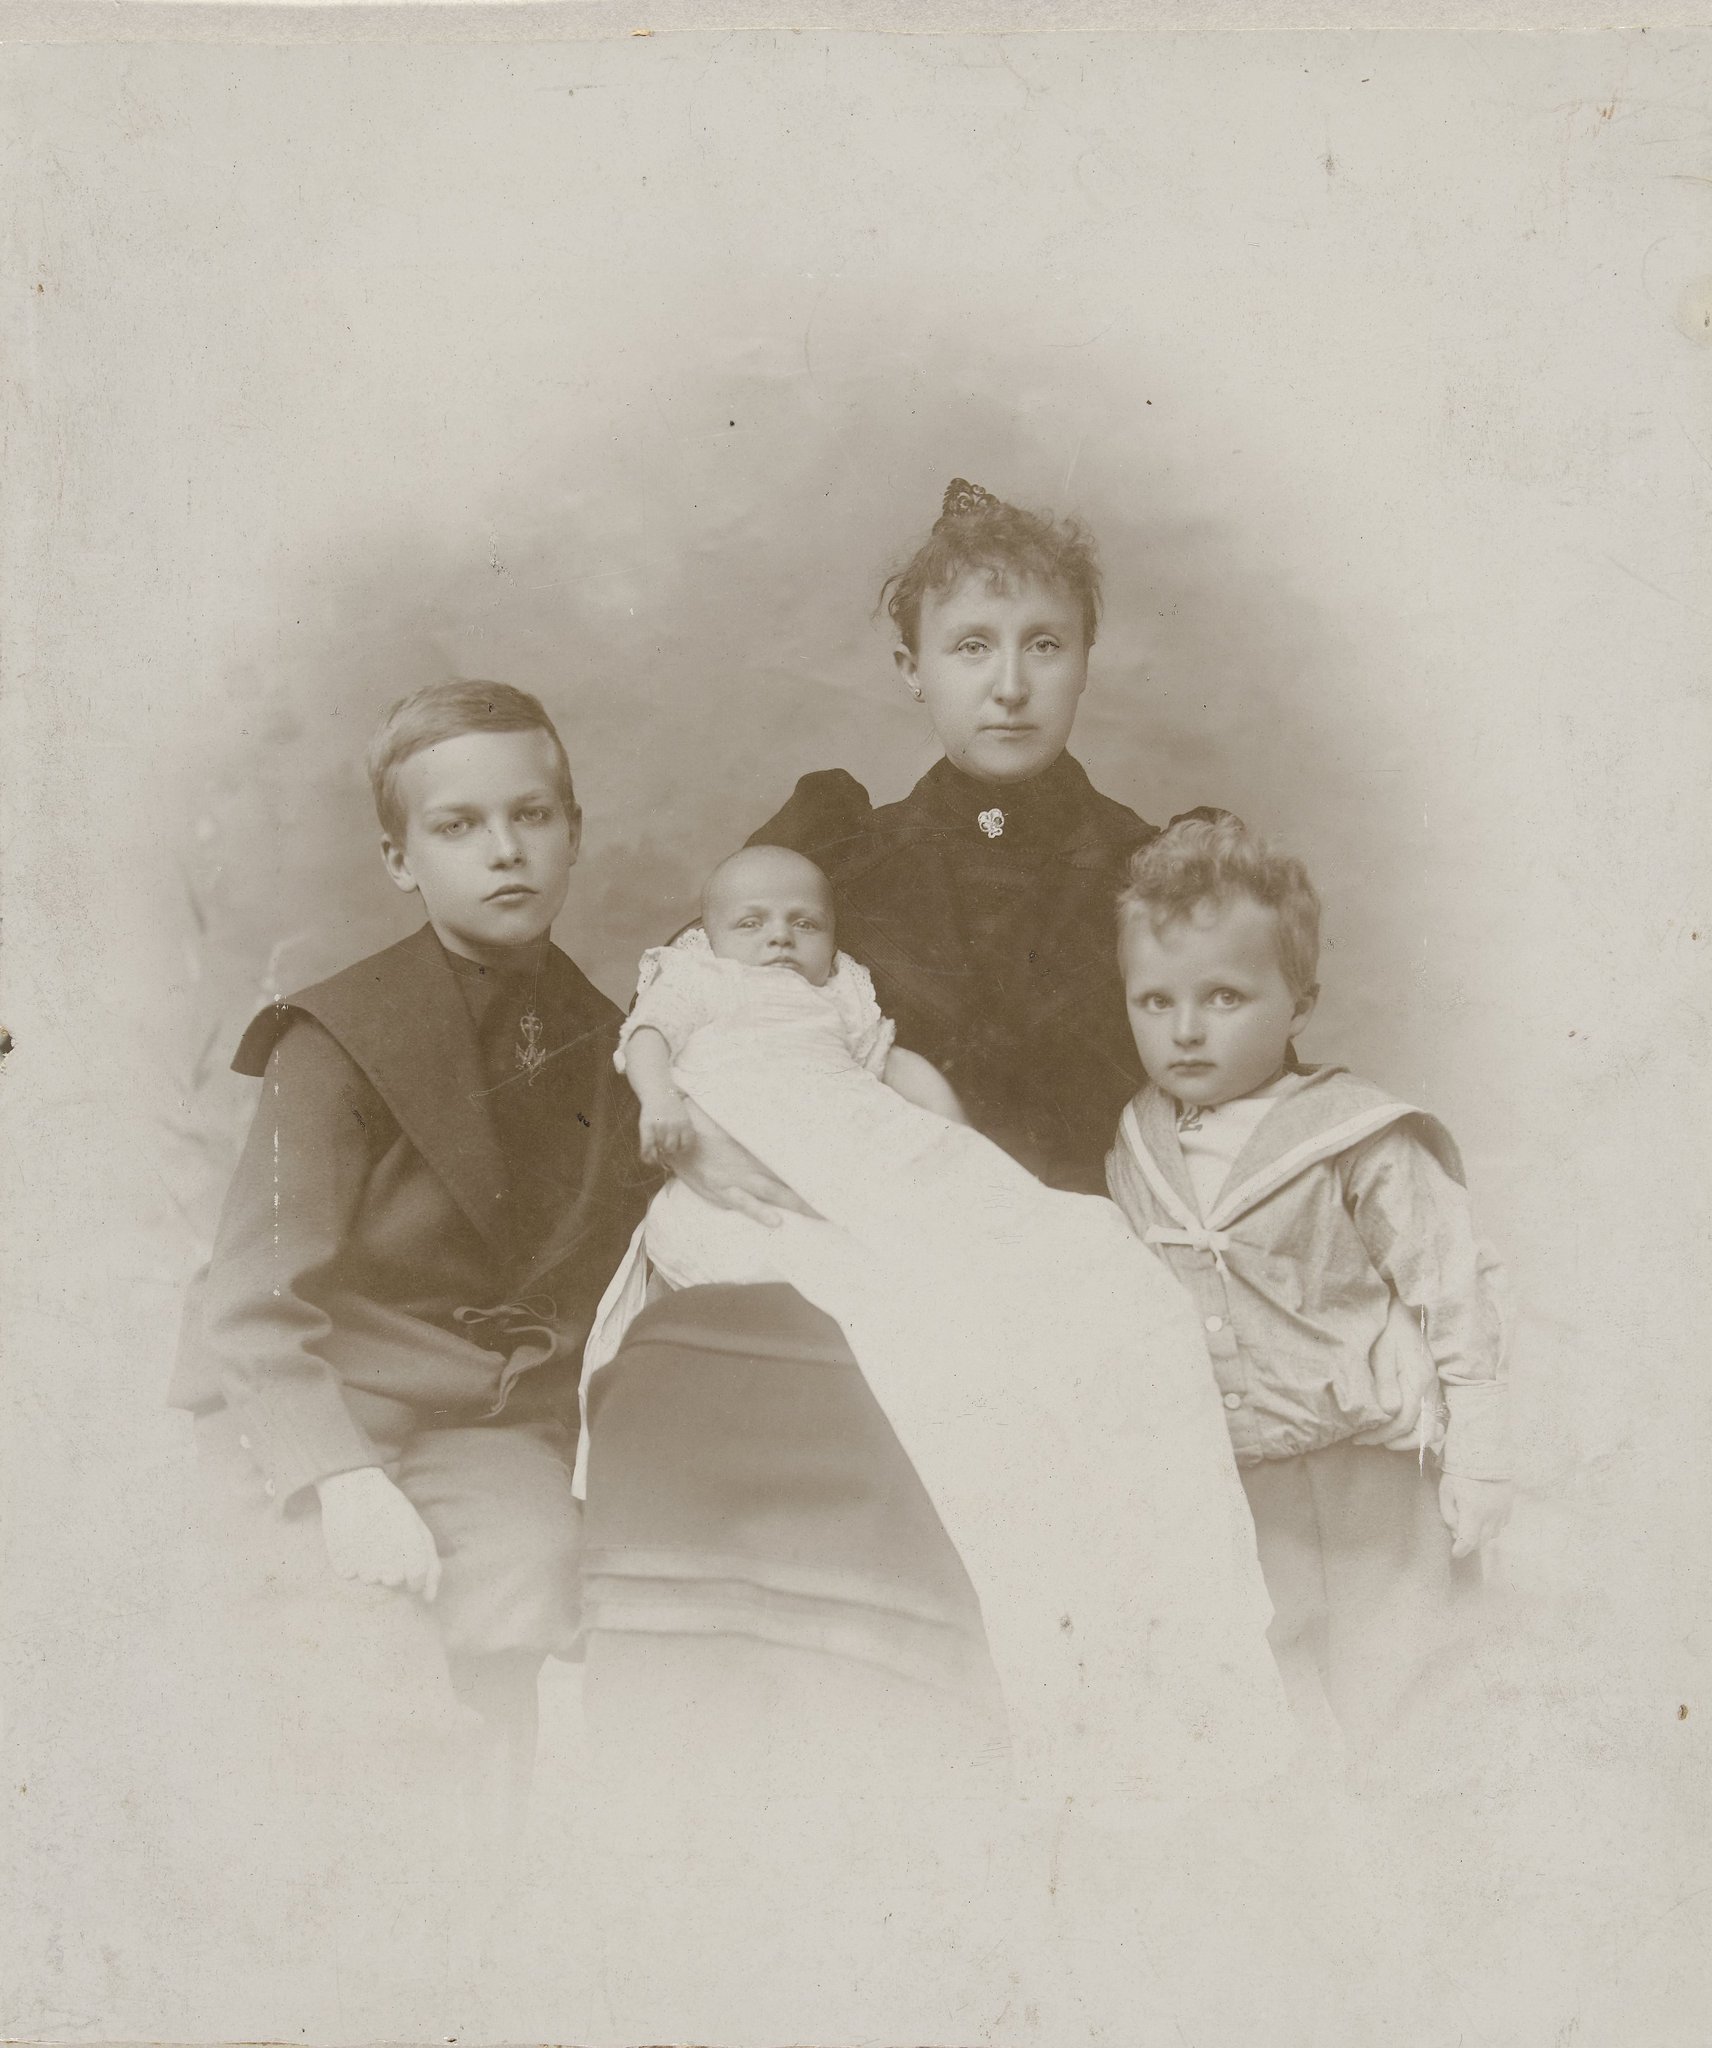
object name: photograph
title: Gezinsportret van vrouw met twee jongens en een baby in een doopjurk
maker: Anonymous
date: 1890-1910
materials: cardboard, photographic support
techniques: albumen print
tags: baptism, christening gown